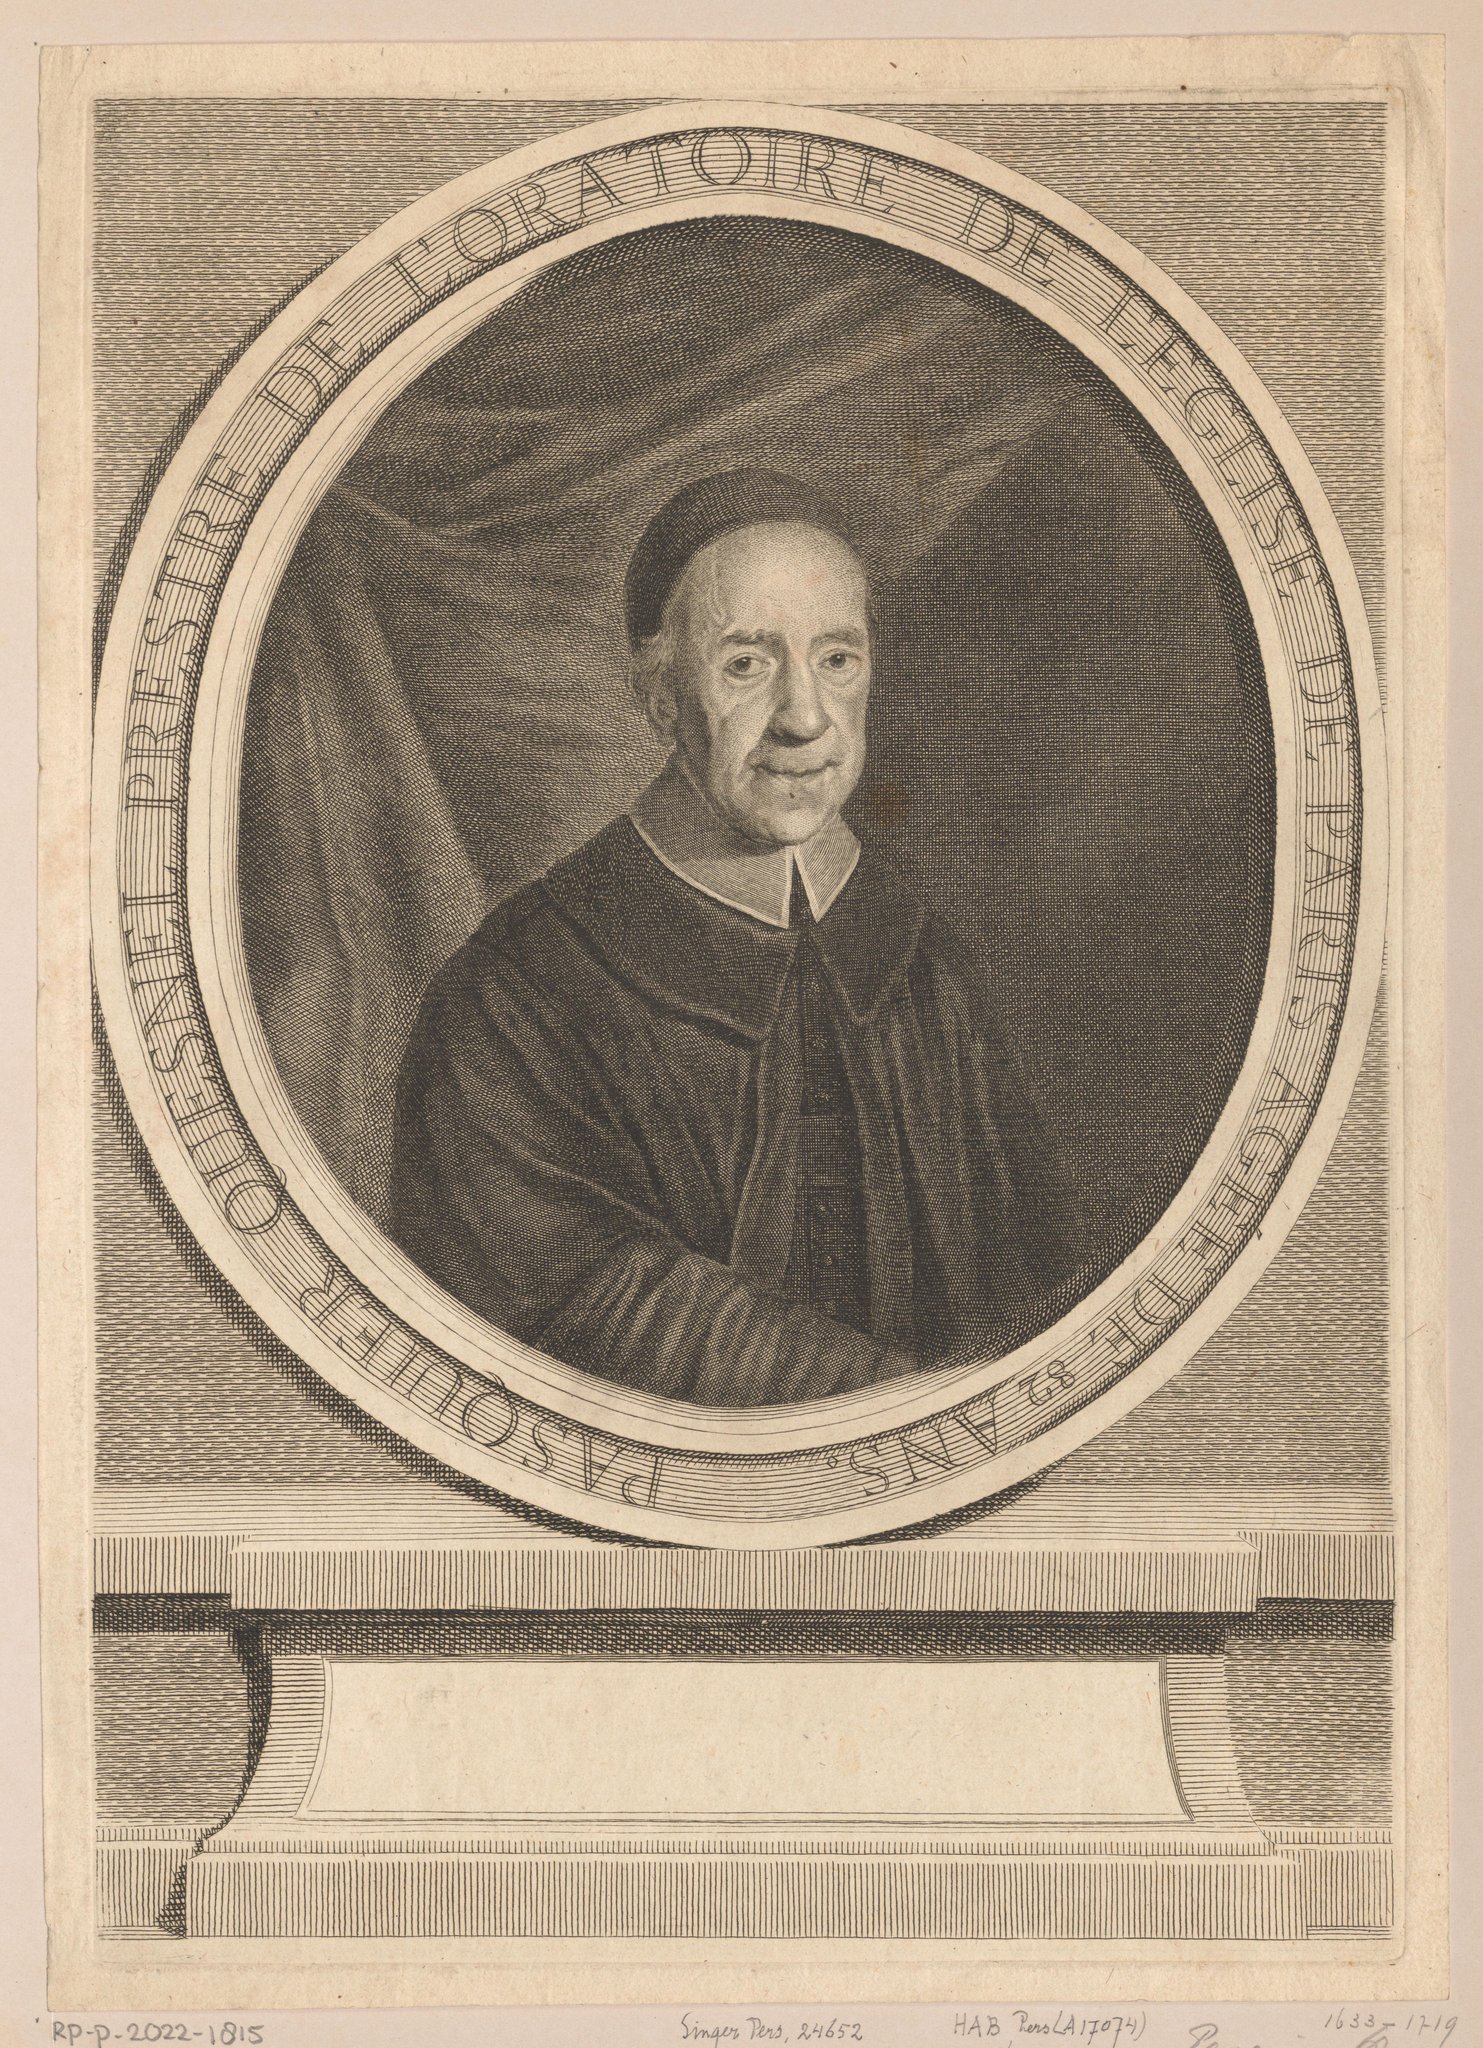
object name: print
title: Portret van Pasquier Quesnel op 82-jarige leeftijd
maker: marie-anne-hyacinthe hortemels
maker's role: print maker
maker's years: 1682-1727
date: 1716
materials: paper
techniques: engraving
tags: theologian, historical persons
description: Met tekst in het Frans rondom het portret.